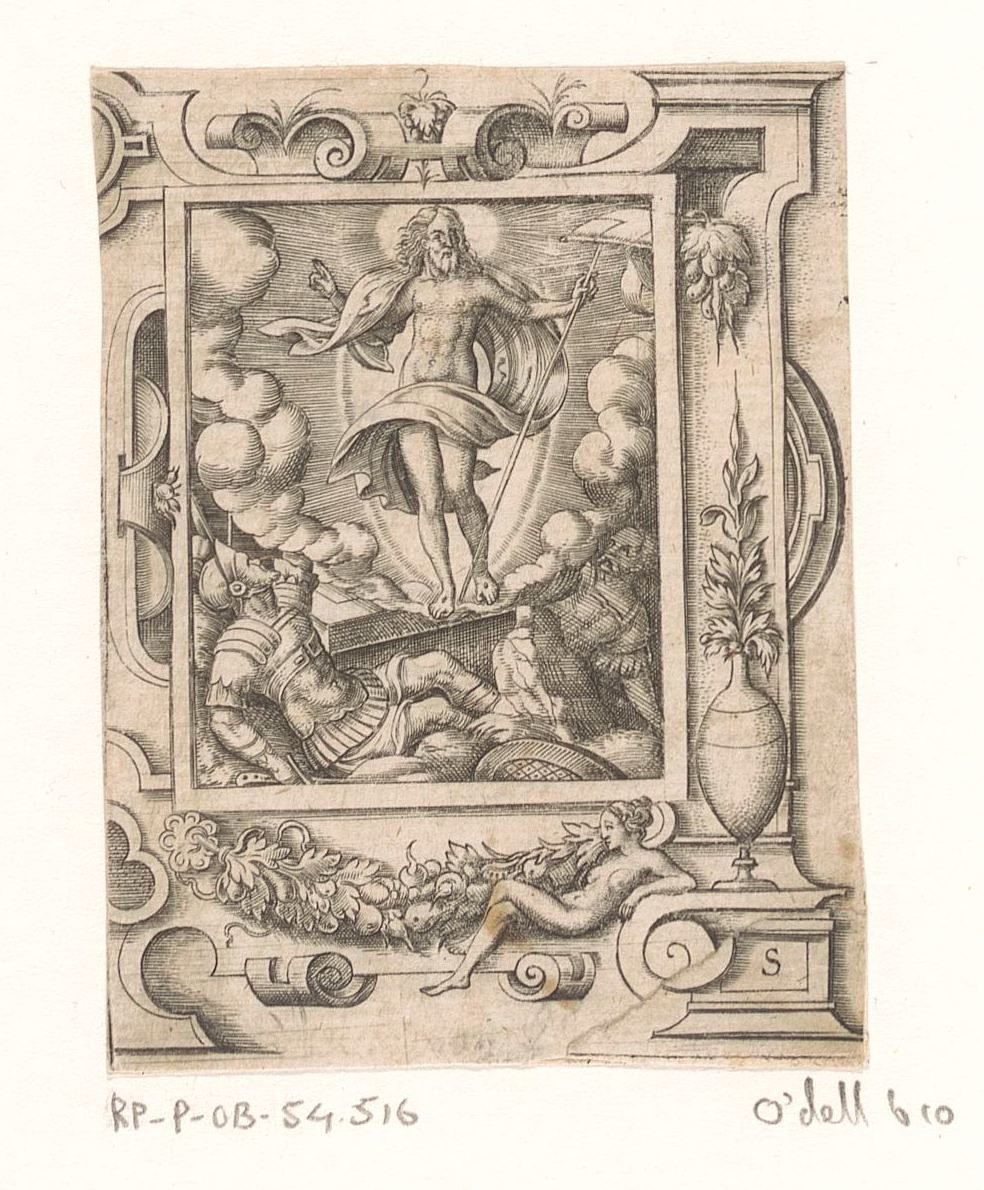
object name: print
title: Opstanding in een rolwerk omlijsting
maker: virgilius solis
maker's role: draughtsman, print maker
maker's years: 1514-1562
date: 1568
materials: paper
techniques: engraving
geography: nuremberg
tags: scrollwork, strapwork ~ ornament, events immediately after the resurrection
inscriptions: number: ‘86’, collector's mark: Lugt 2228, collector's mark: Lugt 240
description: Prent gebruikt voor het gebedenboek: Solis, Virgil. Ein New Künstlich Betbüchlein. Neurenberg: Hieronymus Petri, 1568. Bij elke prent met een Bijbelse scène behoort een genummerde prent met een gebed in het Latijn en in het Duits. Het monogram VS is steeds verspreid over twee bij elkaar horende prenten.